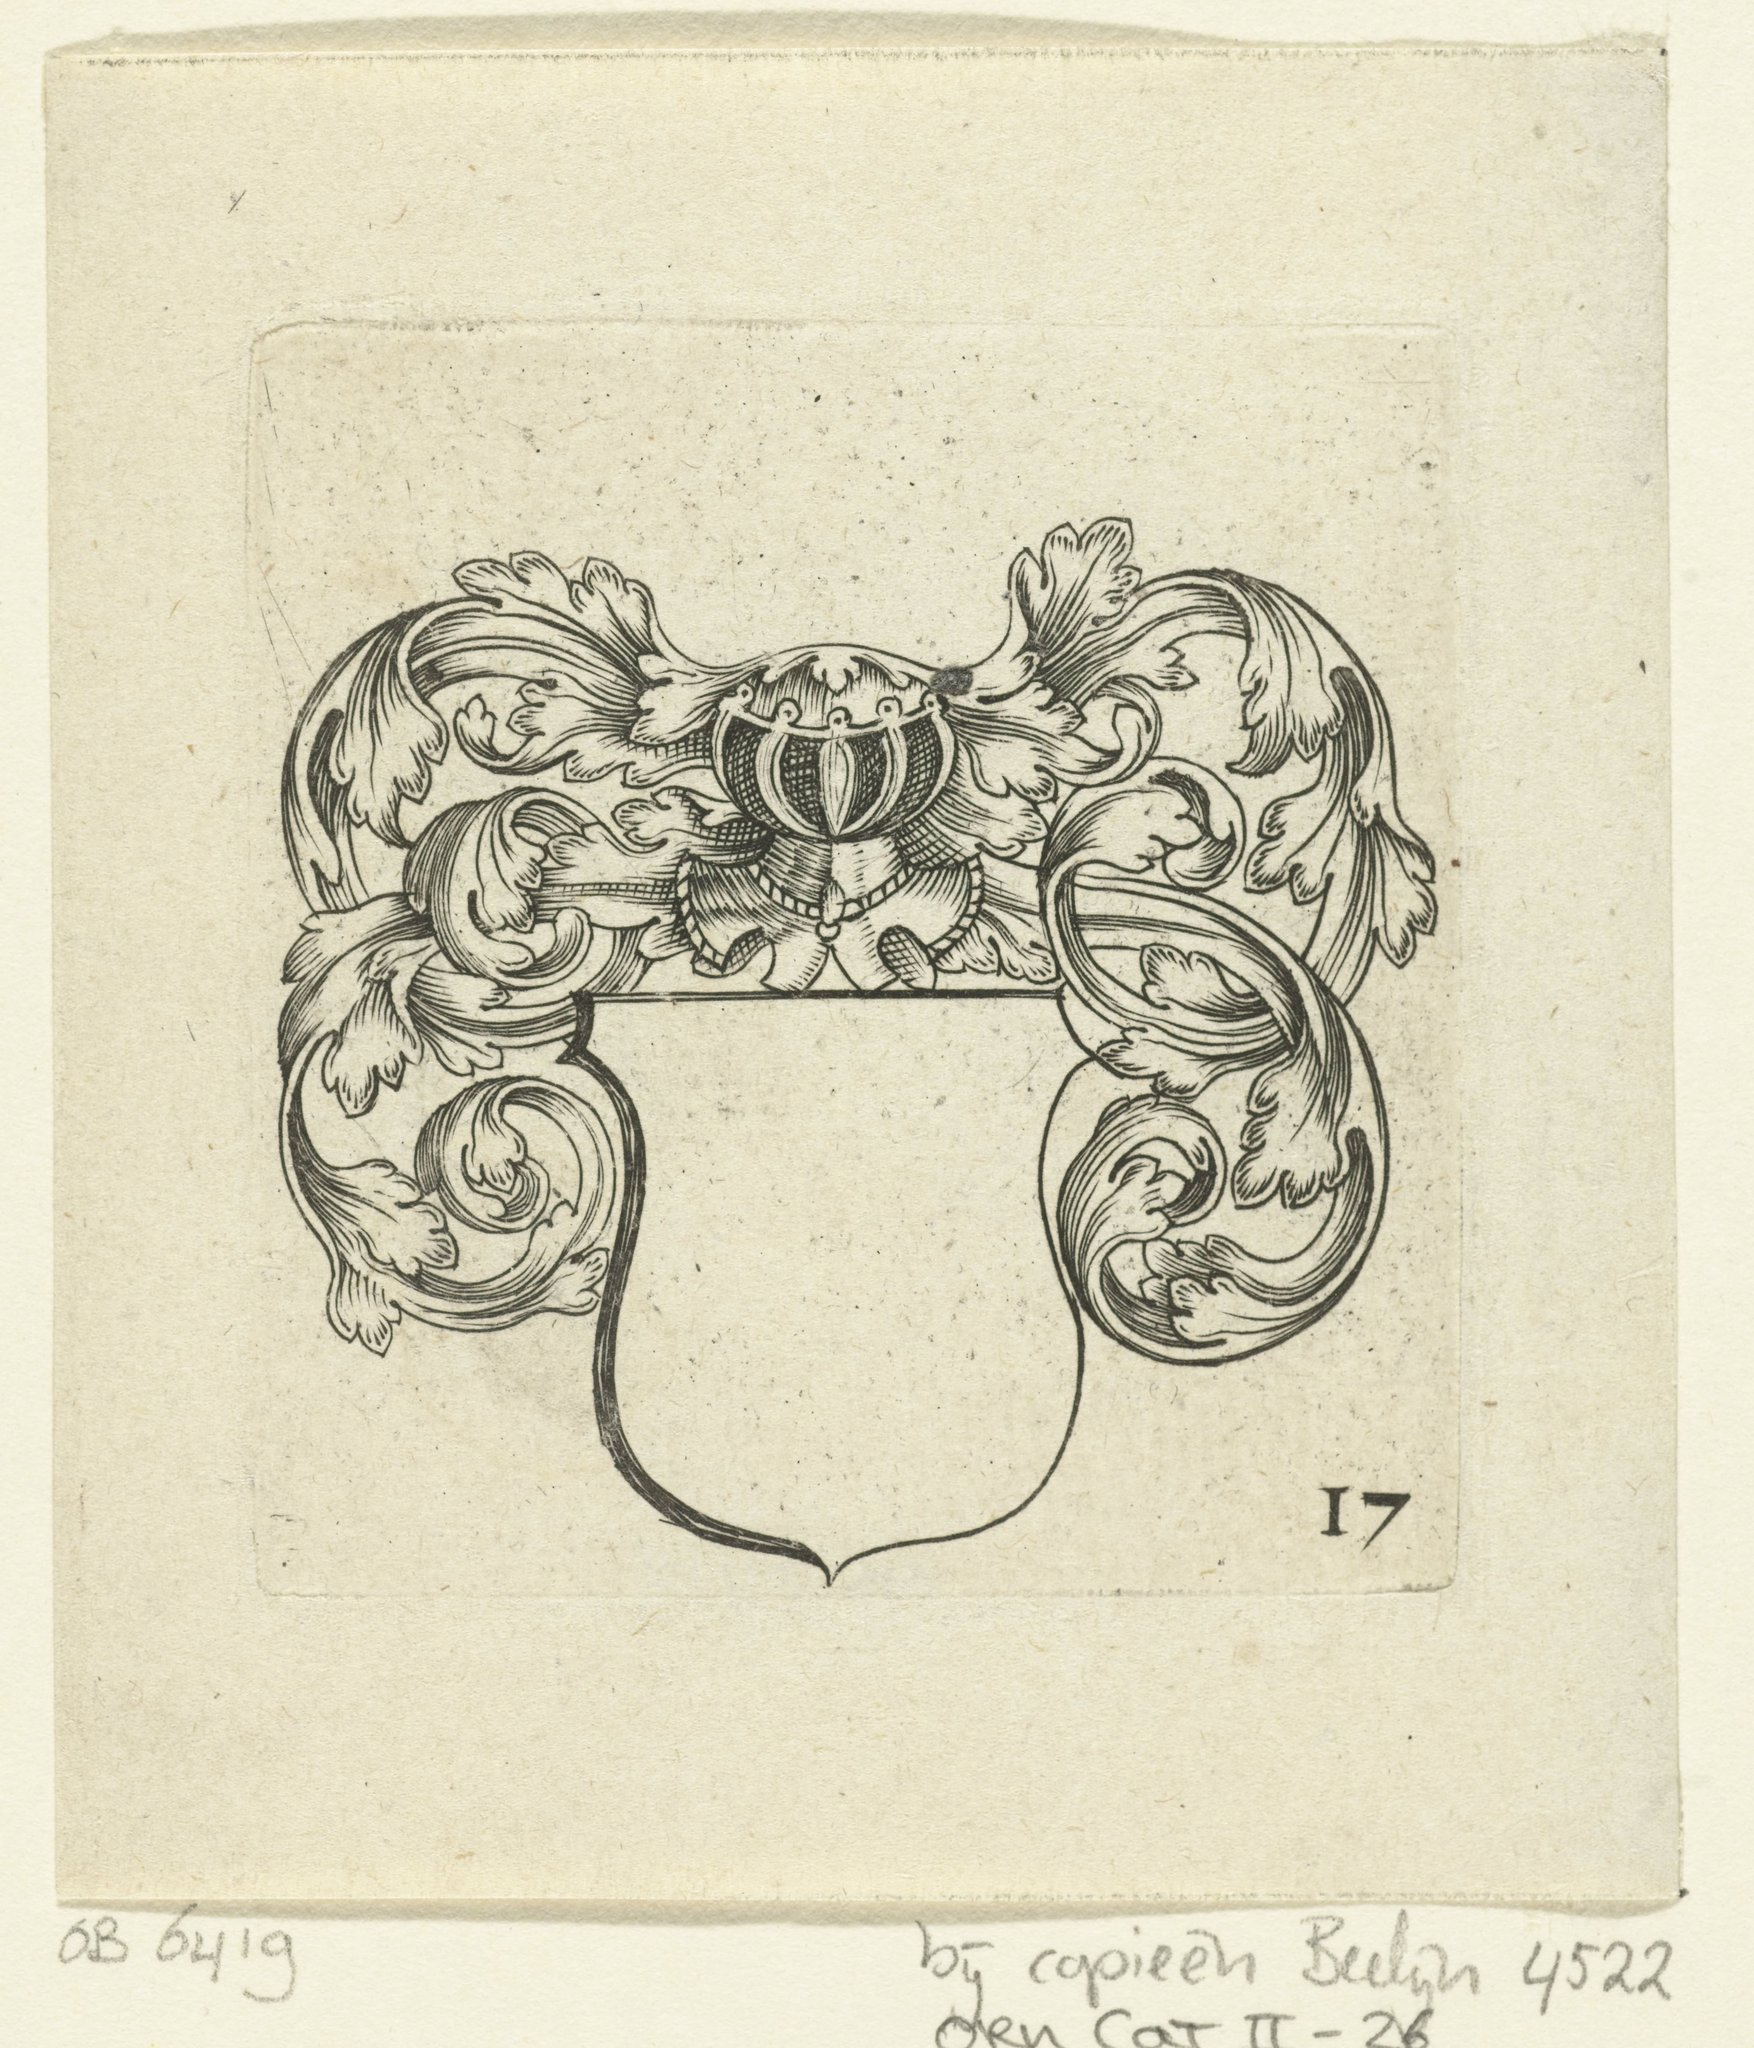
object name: print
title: Wapenschild met helm en bladranken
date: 1625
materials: paper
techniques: engraving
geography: amsterdam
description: Blad uit serie wapenschilden met lege compartimenten.